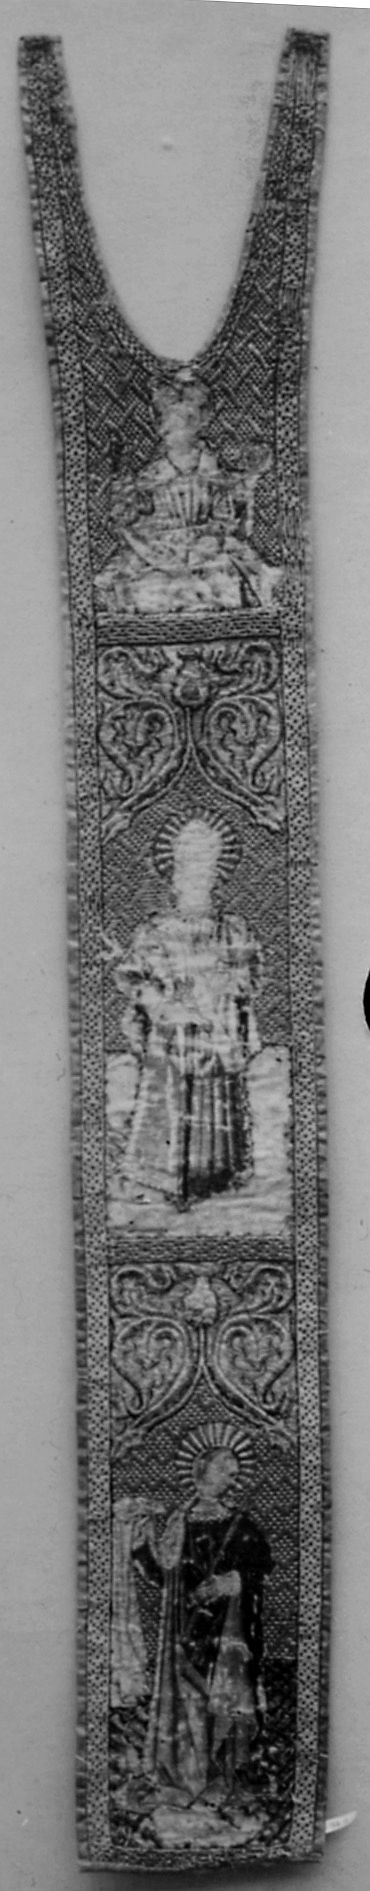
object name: orphrey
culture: spanish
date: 1401-1500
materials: gold thread, silk